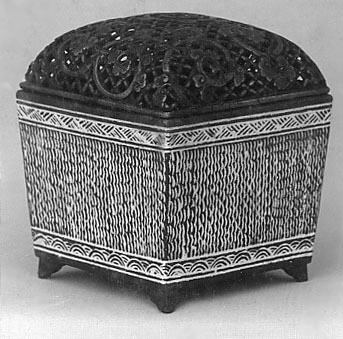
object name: incense burner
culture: japanese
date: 1801-1833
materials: brass, pottery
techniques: inlay